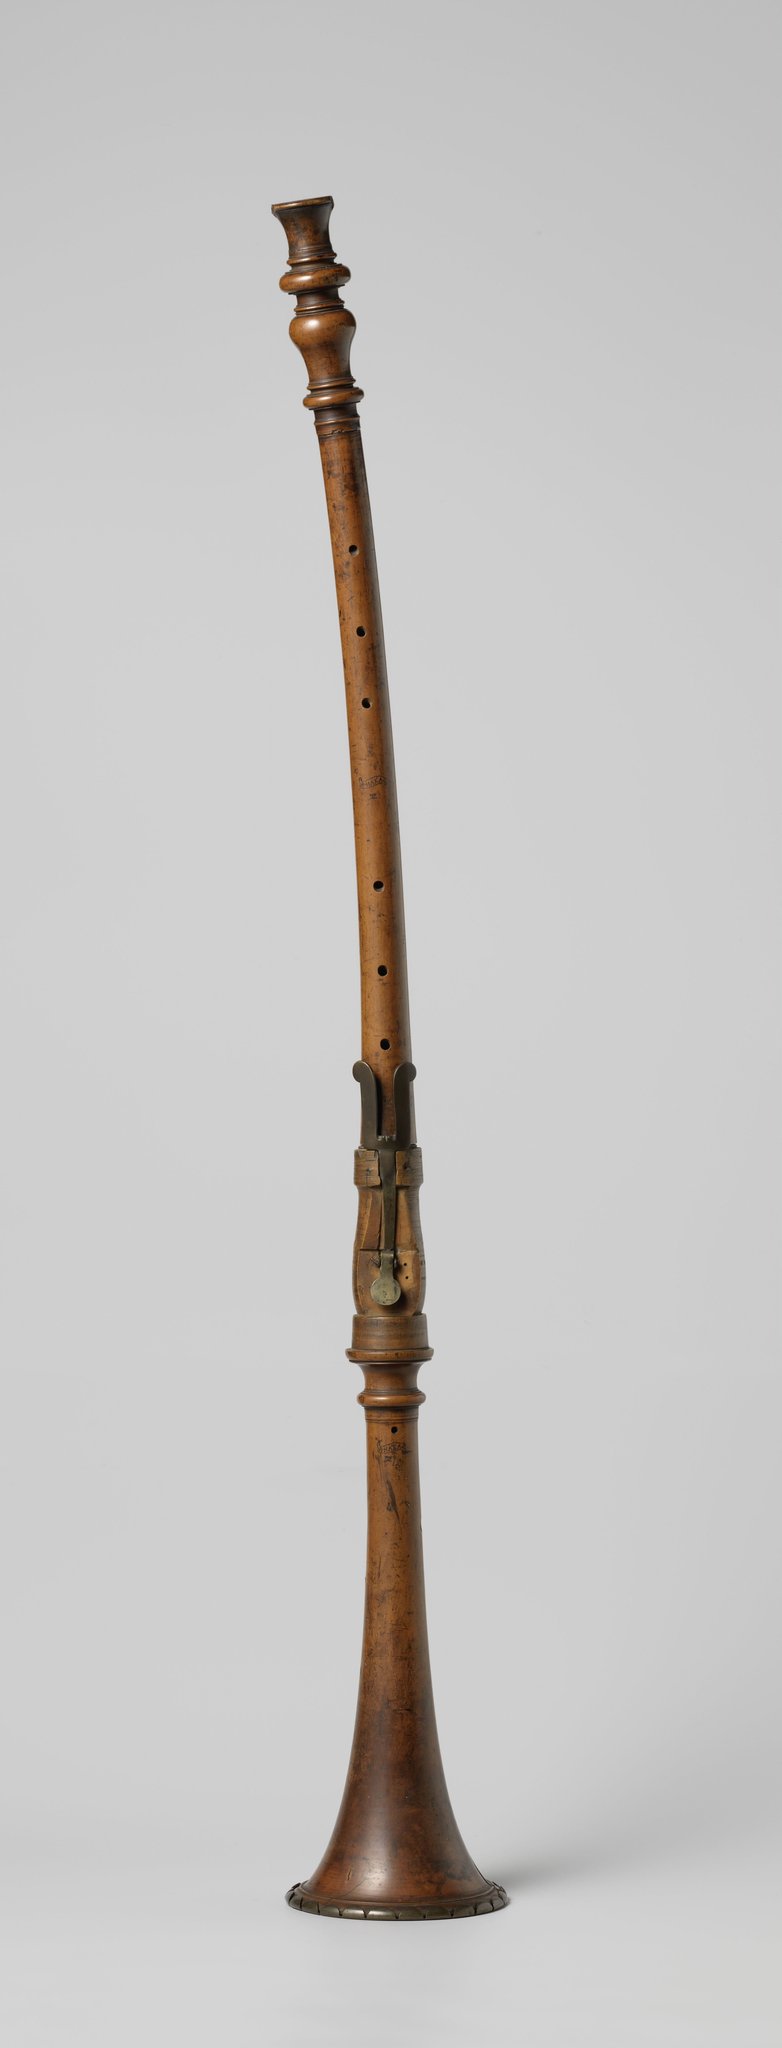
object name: wind instrument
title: Alto Shawm (Duytse Schalmey)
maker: richard haka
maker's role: musical instrument maker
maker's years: 1646-1705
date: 1680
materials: wood, brass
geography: amsterdam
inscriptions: mark, on the top joint under hole 6 and just below the fontanelle hole, stamped: [single fleurs-de-lis], mark, between the 3rd and 4th tone holes, and on the bell just below the small resonance hole, stamped: R.HAKA [in scroll]/ [fleur de-lis]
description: Music has always been a crucial element of public celebrations, such as military parades, coronations, royal weddings, and funerals, adding grandeur to the solemnity of the occasion. Musical ensembles entrusted with performing music at these events have existed in Europe since the Middle Ages. This display highlights various marching bands and their musical instruments dating from the 16th to the 19th century.